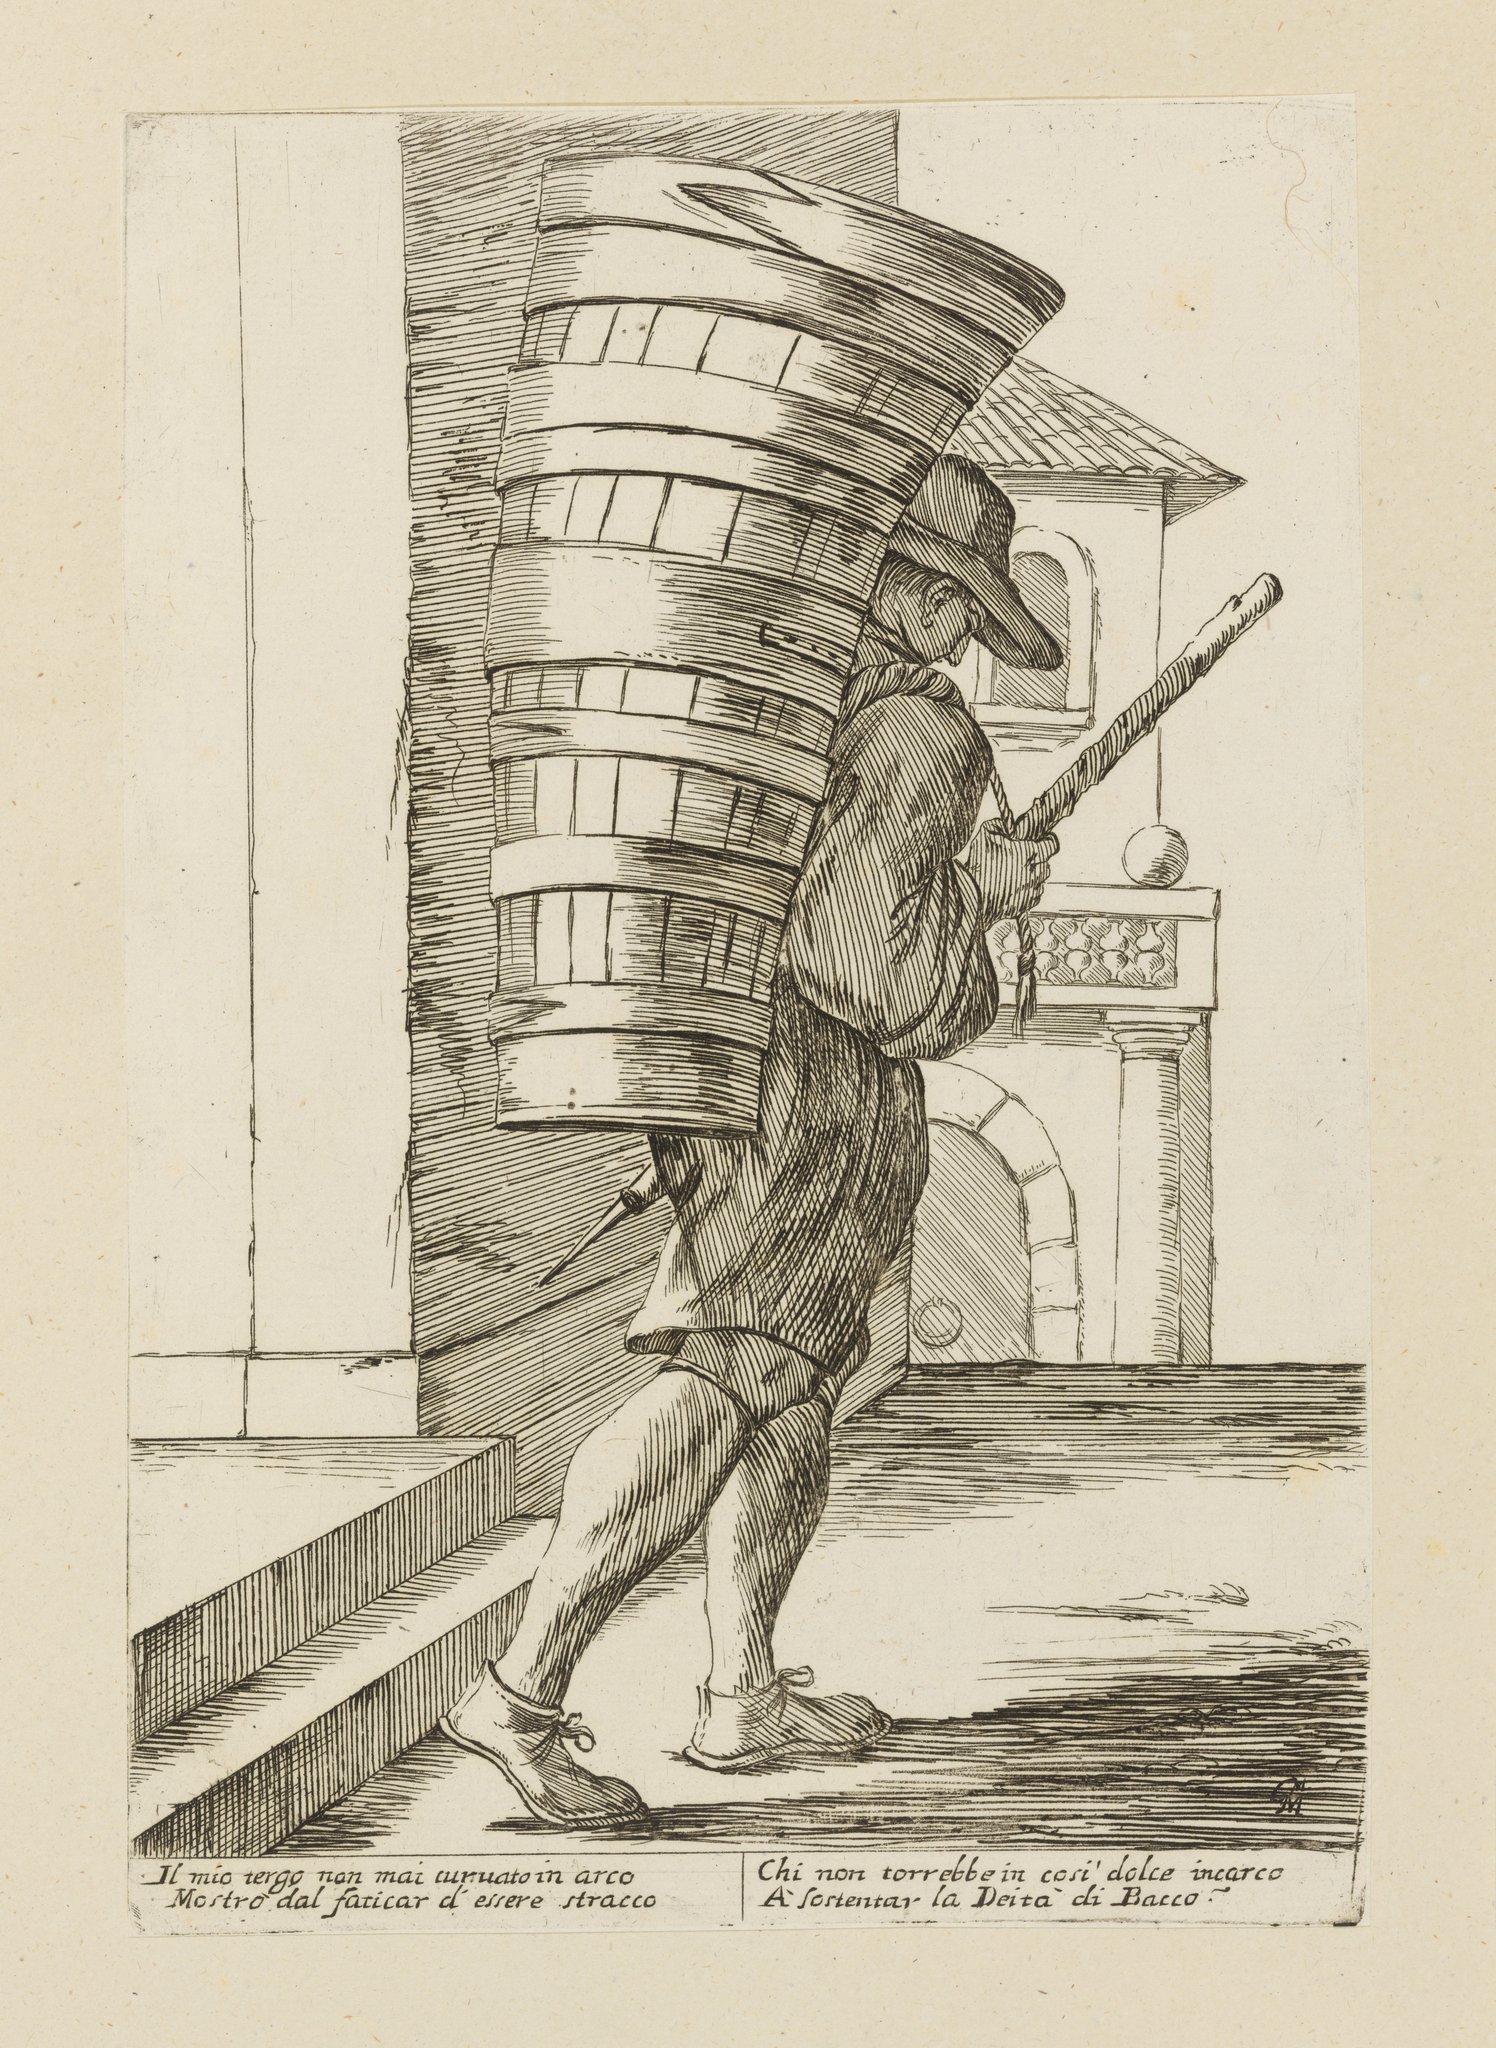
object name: print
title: Man Carrying a Barrel of Wine, from Di Bologna l'Arti per via D'An.ibal' Ca.rac, plate 36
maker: giuseppe maria mitelli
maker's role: artist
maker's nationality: italian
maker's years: 1634-1718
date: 1660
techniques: etching